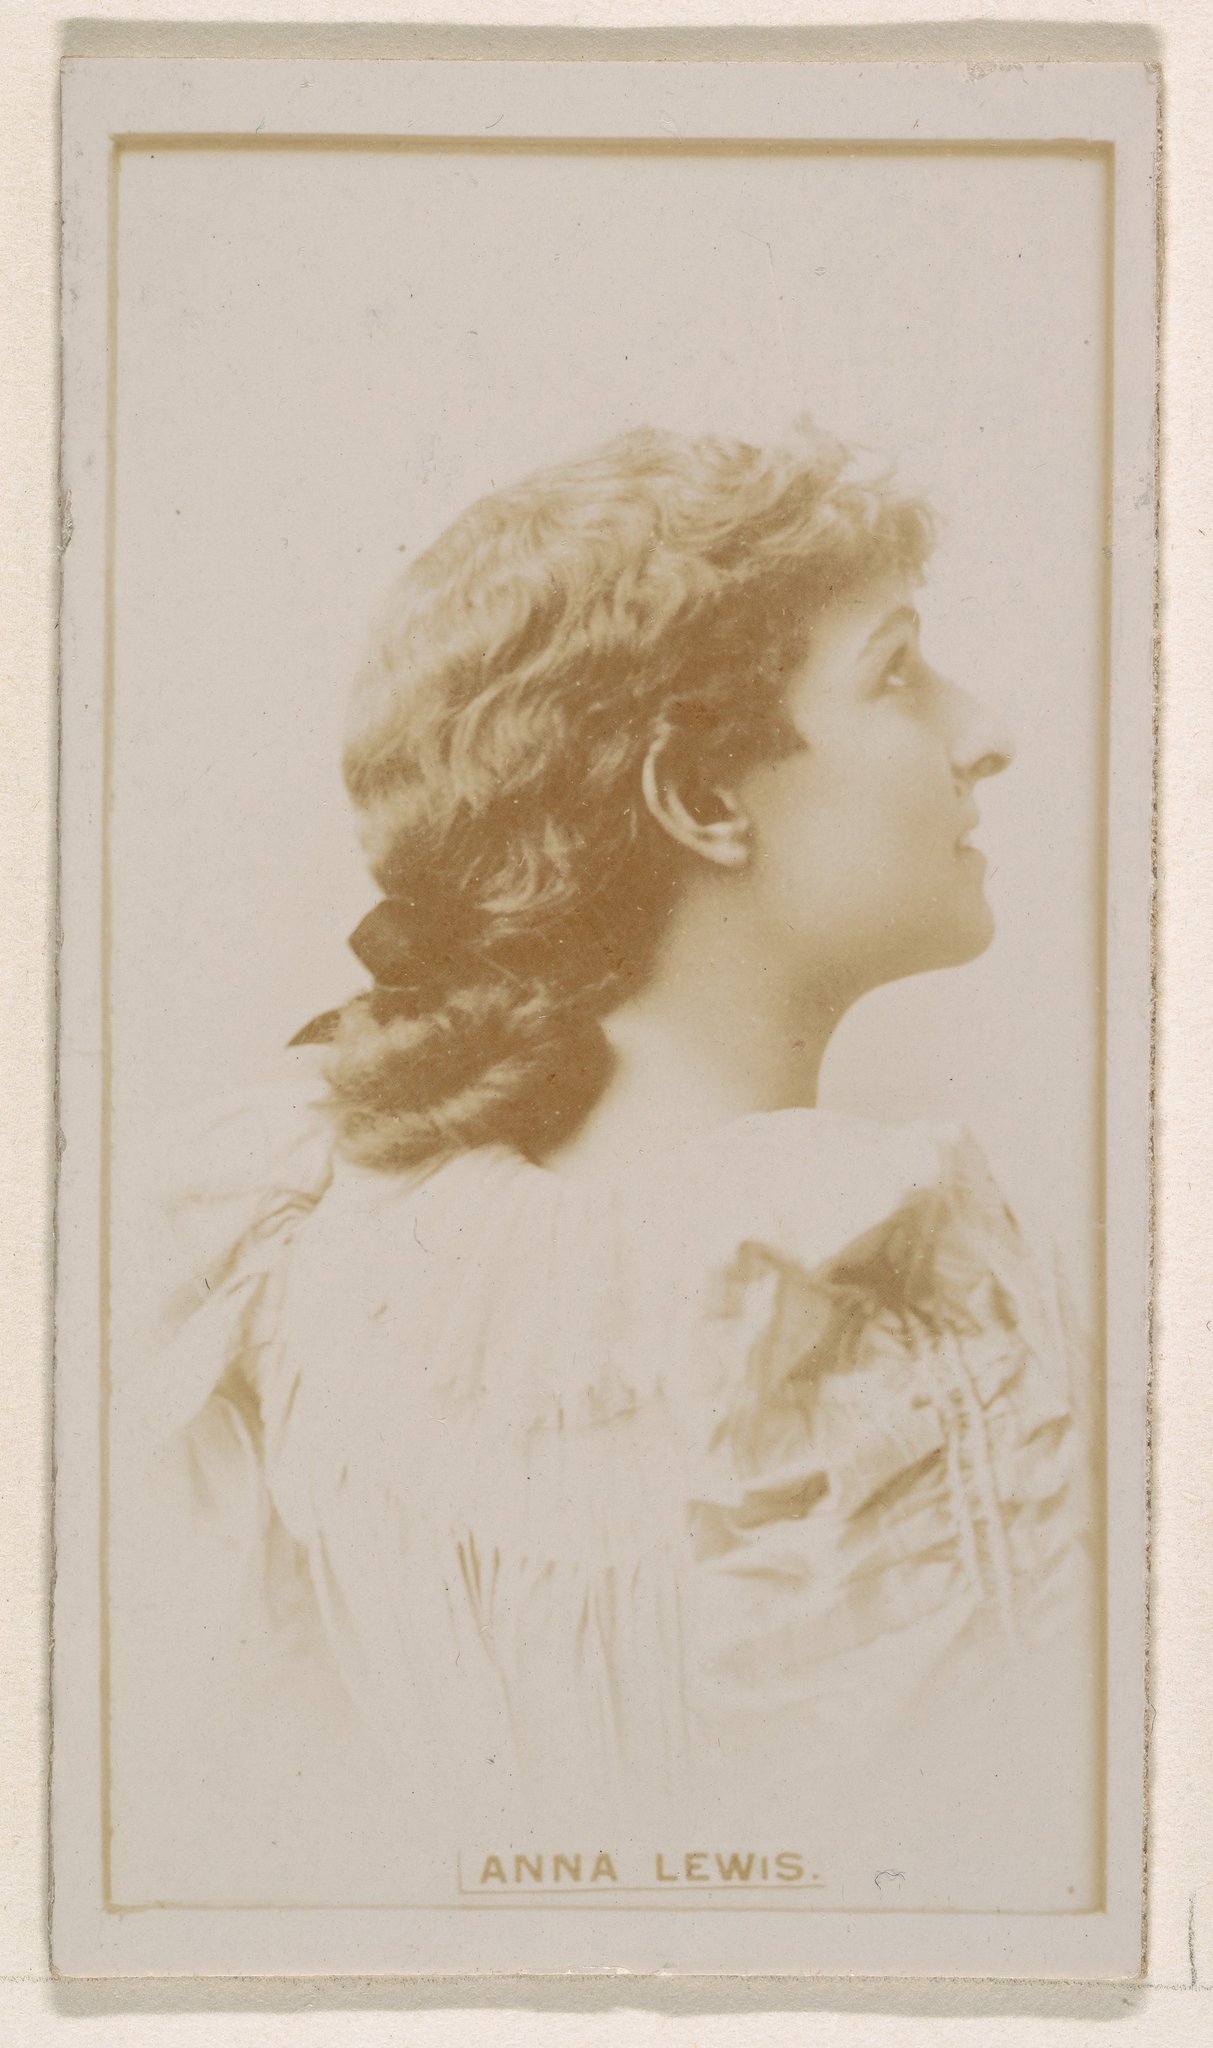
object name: photograph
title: Anna Lewis, from the Actresses series (N245) issued by Kinney Brothers to promote Sweet Caporal Cigarettes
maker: kinney brothers tobacco company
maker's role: publisher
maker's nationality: american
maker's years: 1869-2011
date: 1890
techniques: albumen silver print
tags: women,actresses